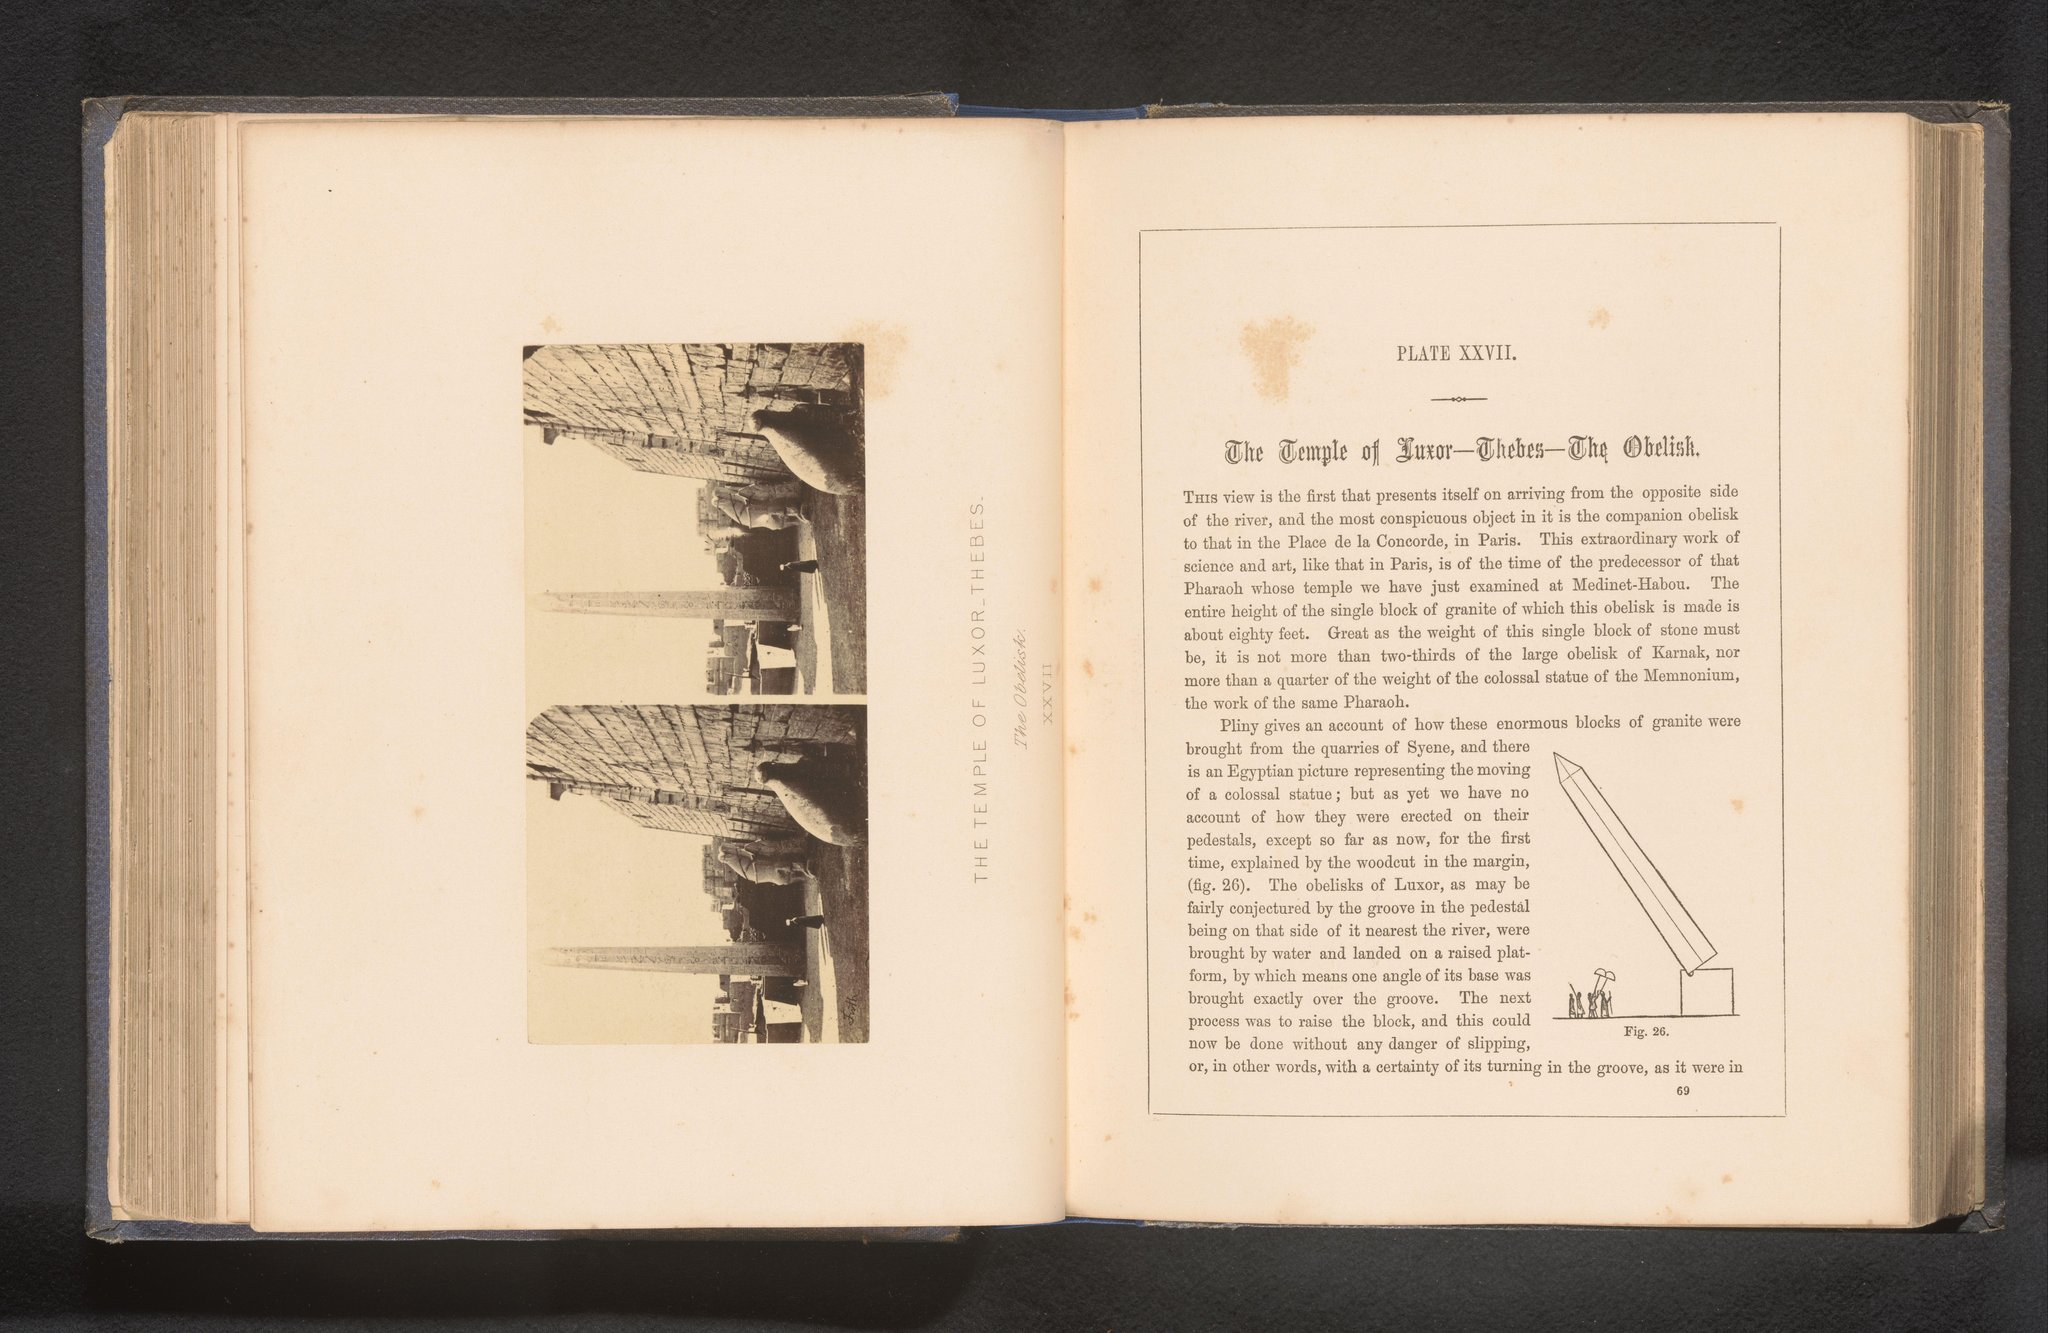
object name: stereograph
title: The temple of Luxor - Thebes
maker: francis frith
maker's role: publisher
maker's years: 1822-1898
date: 1857-1862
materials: photographic support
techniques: albumen print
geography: luxor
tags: obelisk, needle, temple, shrine ~ egyptian religion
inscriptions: inscription: ‘The Obelisk’, number: ‘XXVII’, name: ‘Frith’